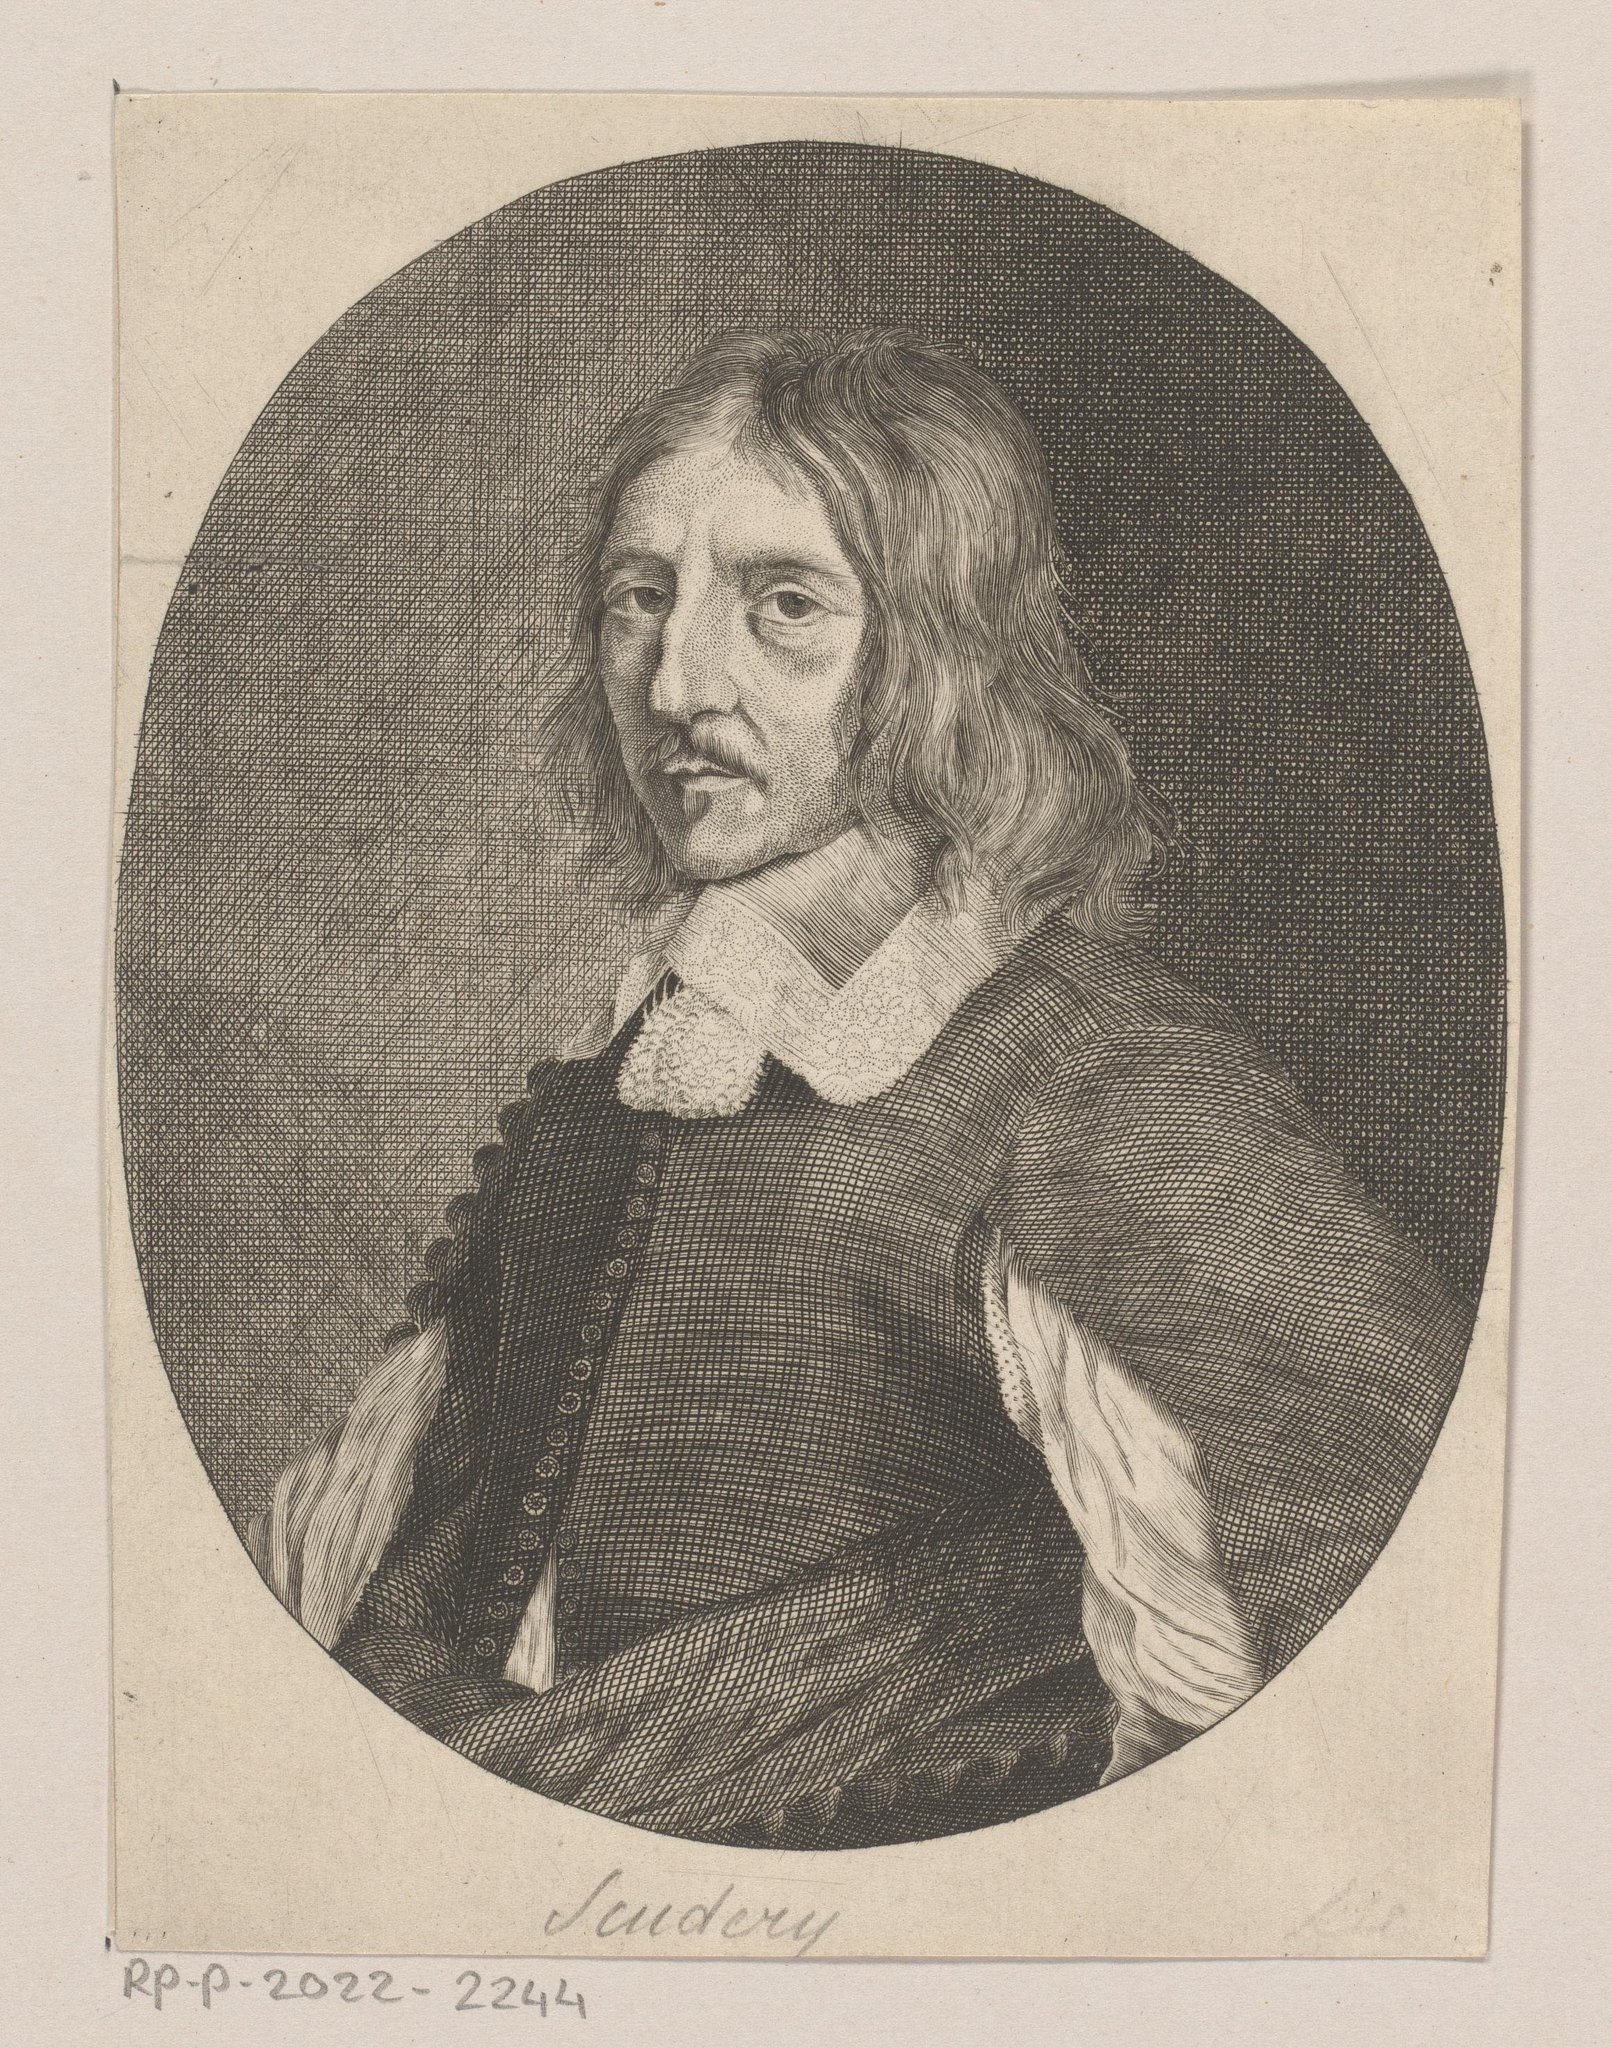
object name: print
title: Portret van Georges de Scudéry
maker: Anonymous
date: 1654-1699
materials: paper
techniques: engraving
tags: le havre, paris, georges de scudéry, historical persons, portrait of a writer, writer, poet, author